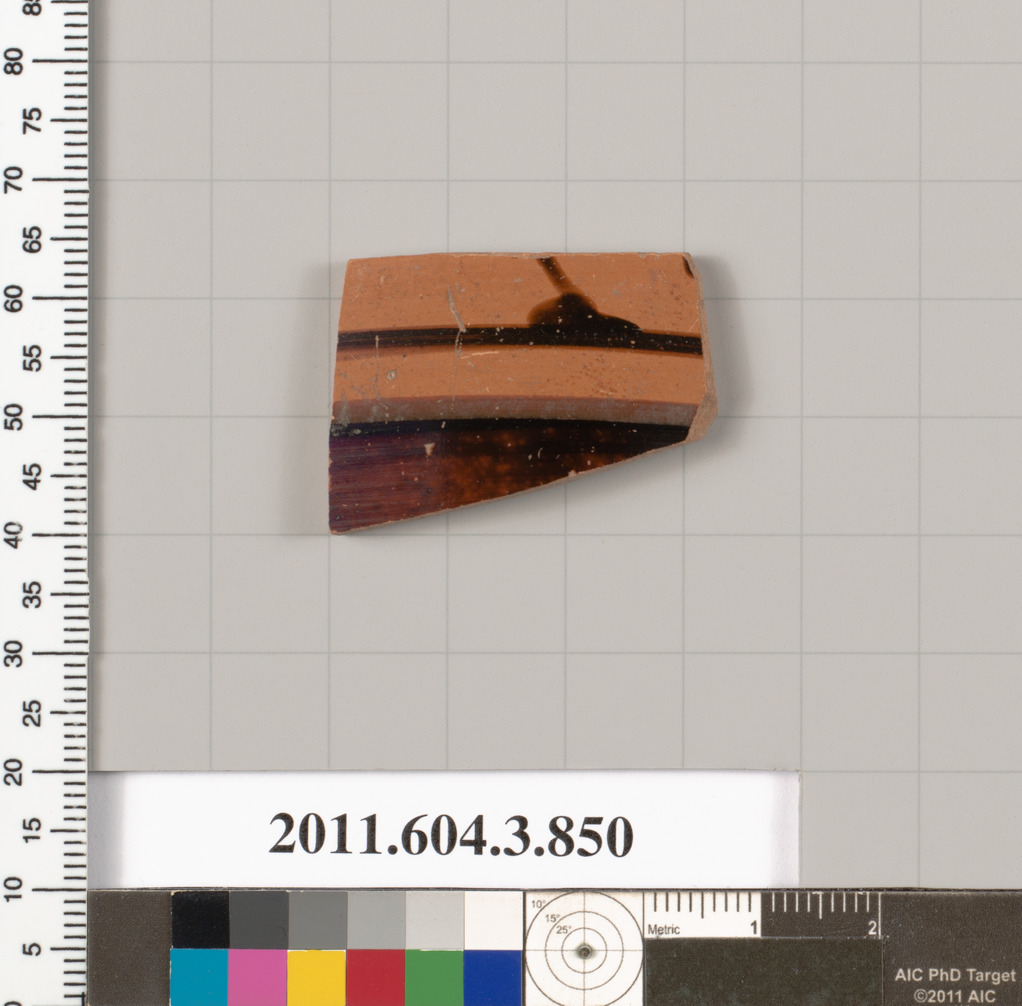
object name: lekythos fragment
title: Terracotta fragment of a lekythos (oil flask)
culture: greek, attic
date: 534-468 BCE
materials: terracotta